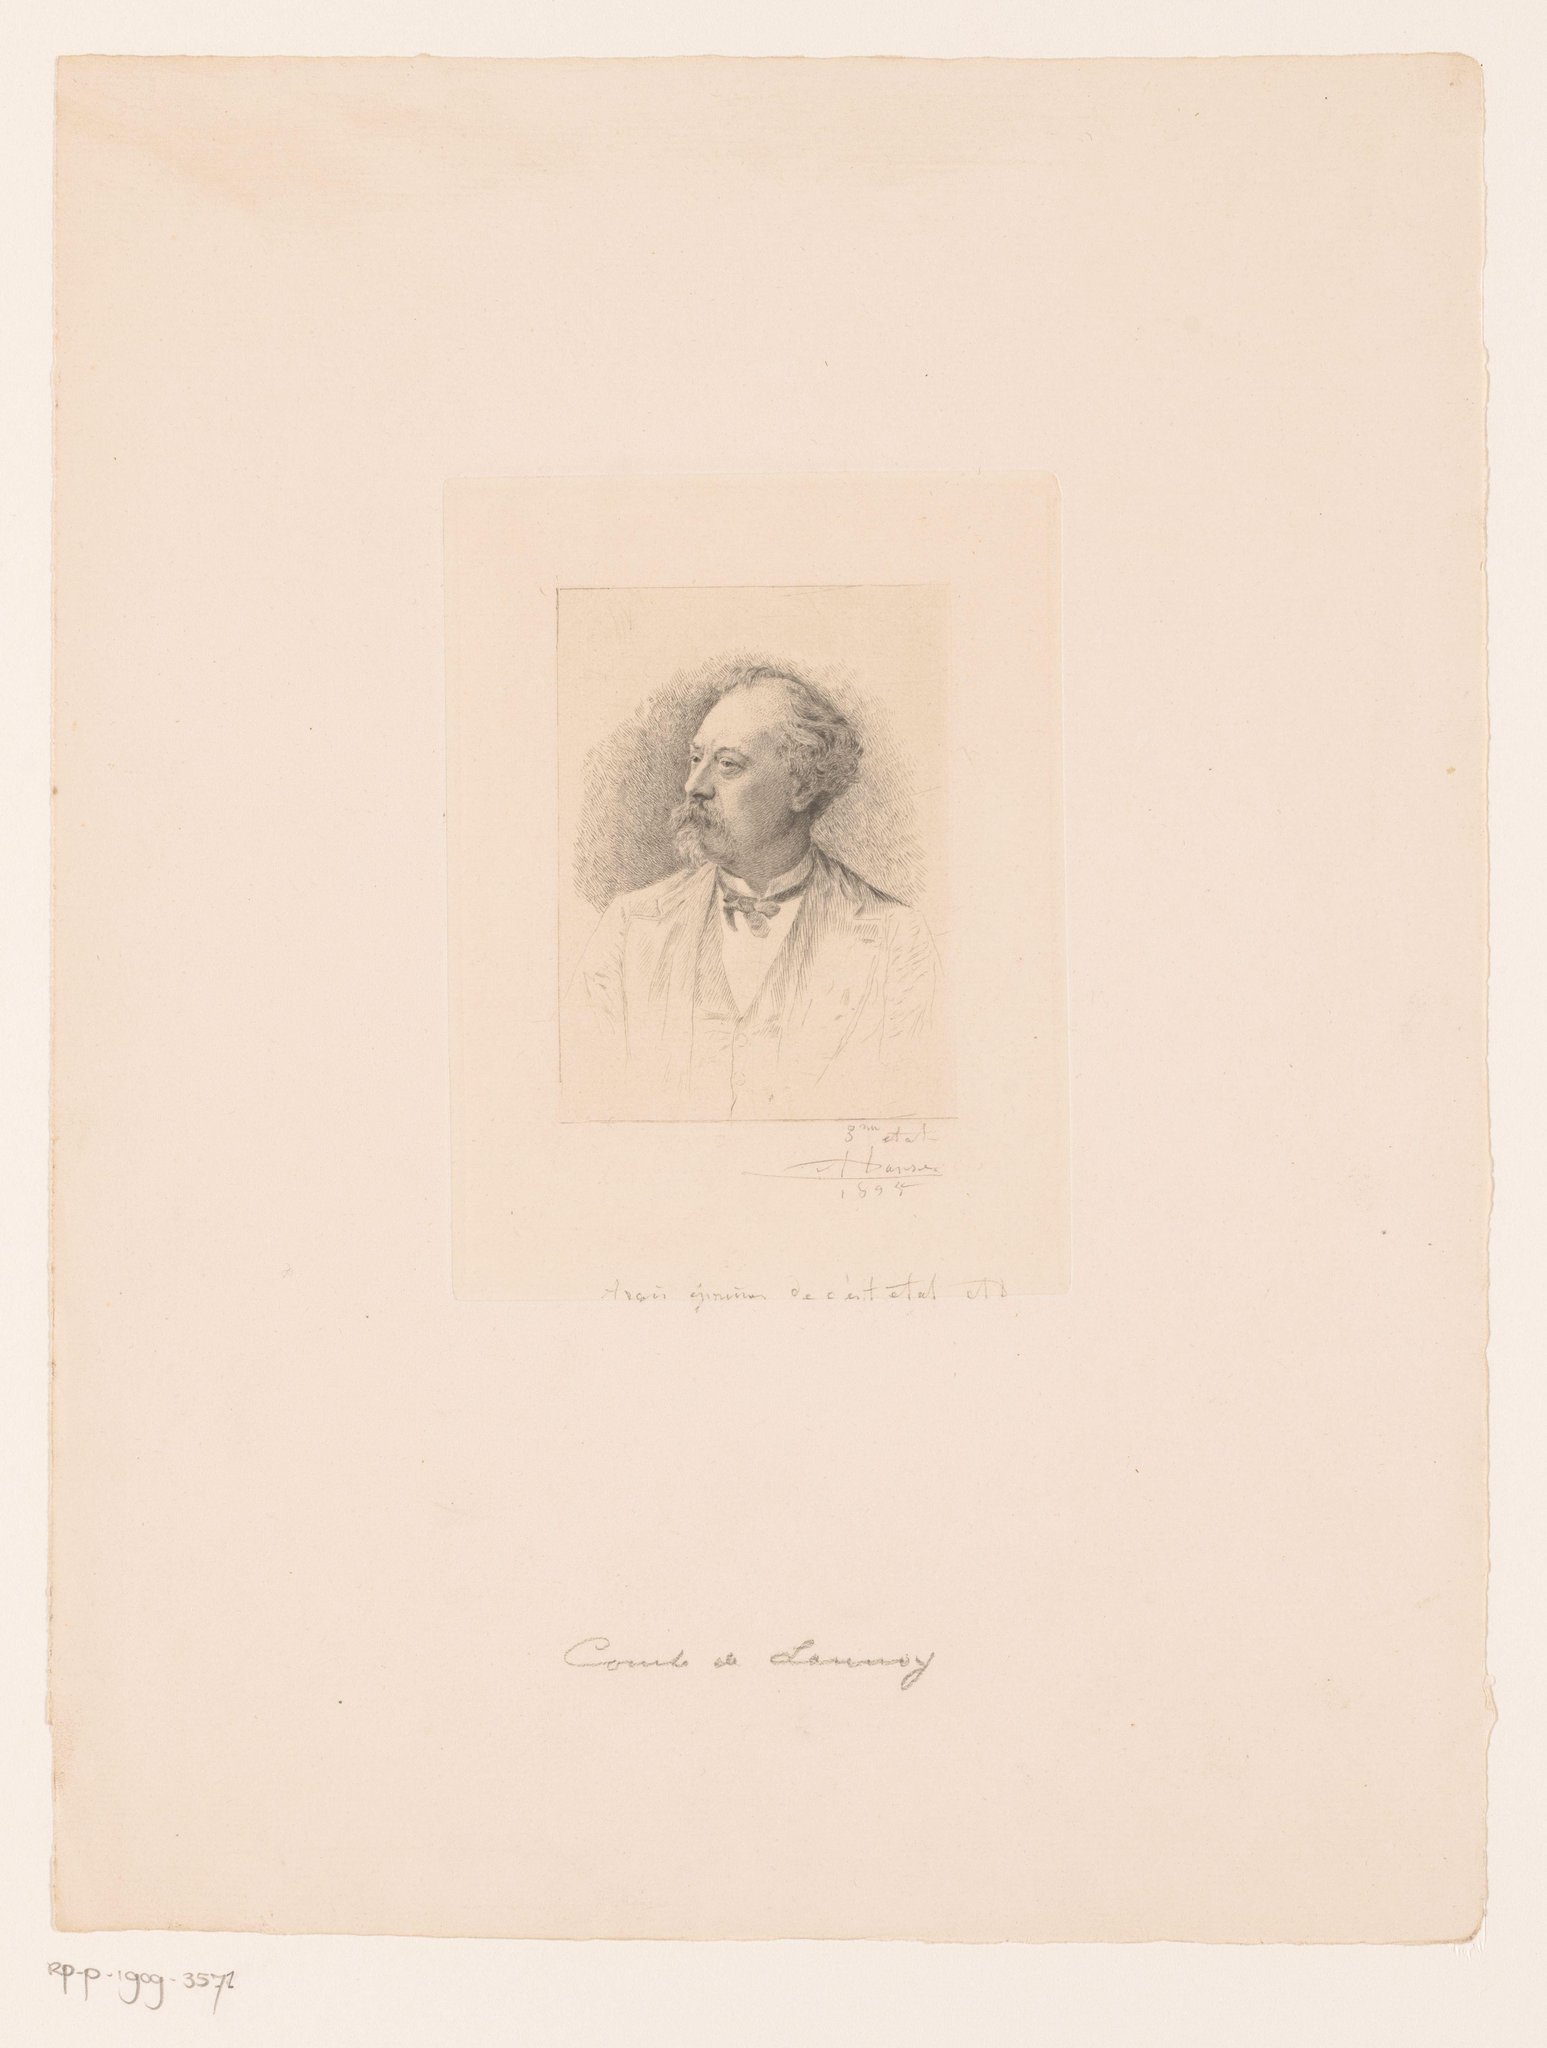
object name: print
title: Portret van Charles graaf van Lannoy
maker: auguste danse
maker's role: print maker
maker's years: 1829-1929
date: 1895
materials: paper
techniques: etching, intaglio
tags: mayor, historical person (...) - historical person (...) portrayed alone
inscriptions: watermark: ‘MBM’, collector's mark: Lugt 2228, annotation: ‘3me état; trois épreuves de c'est etat’